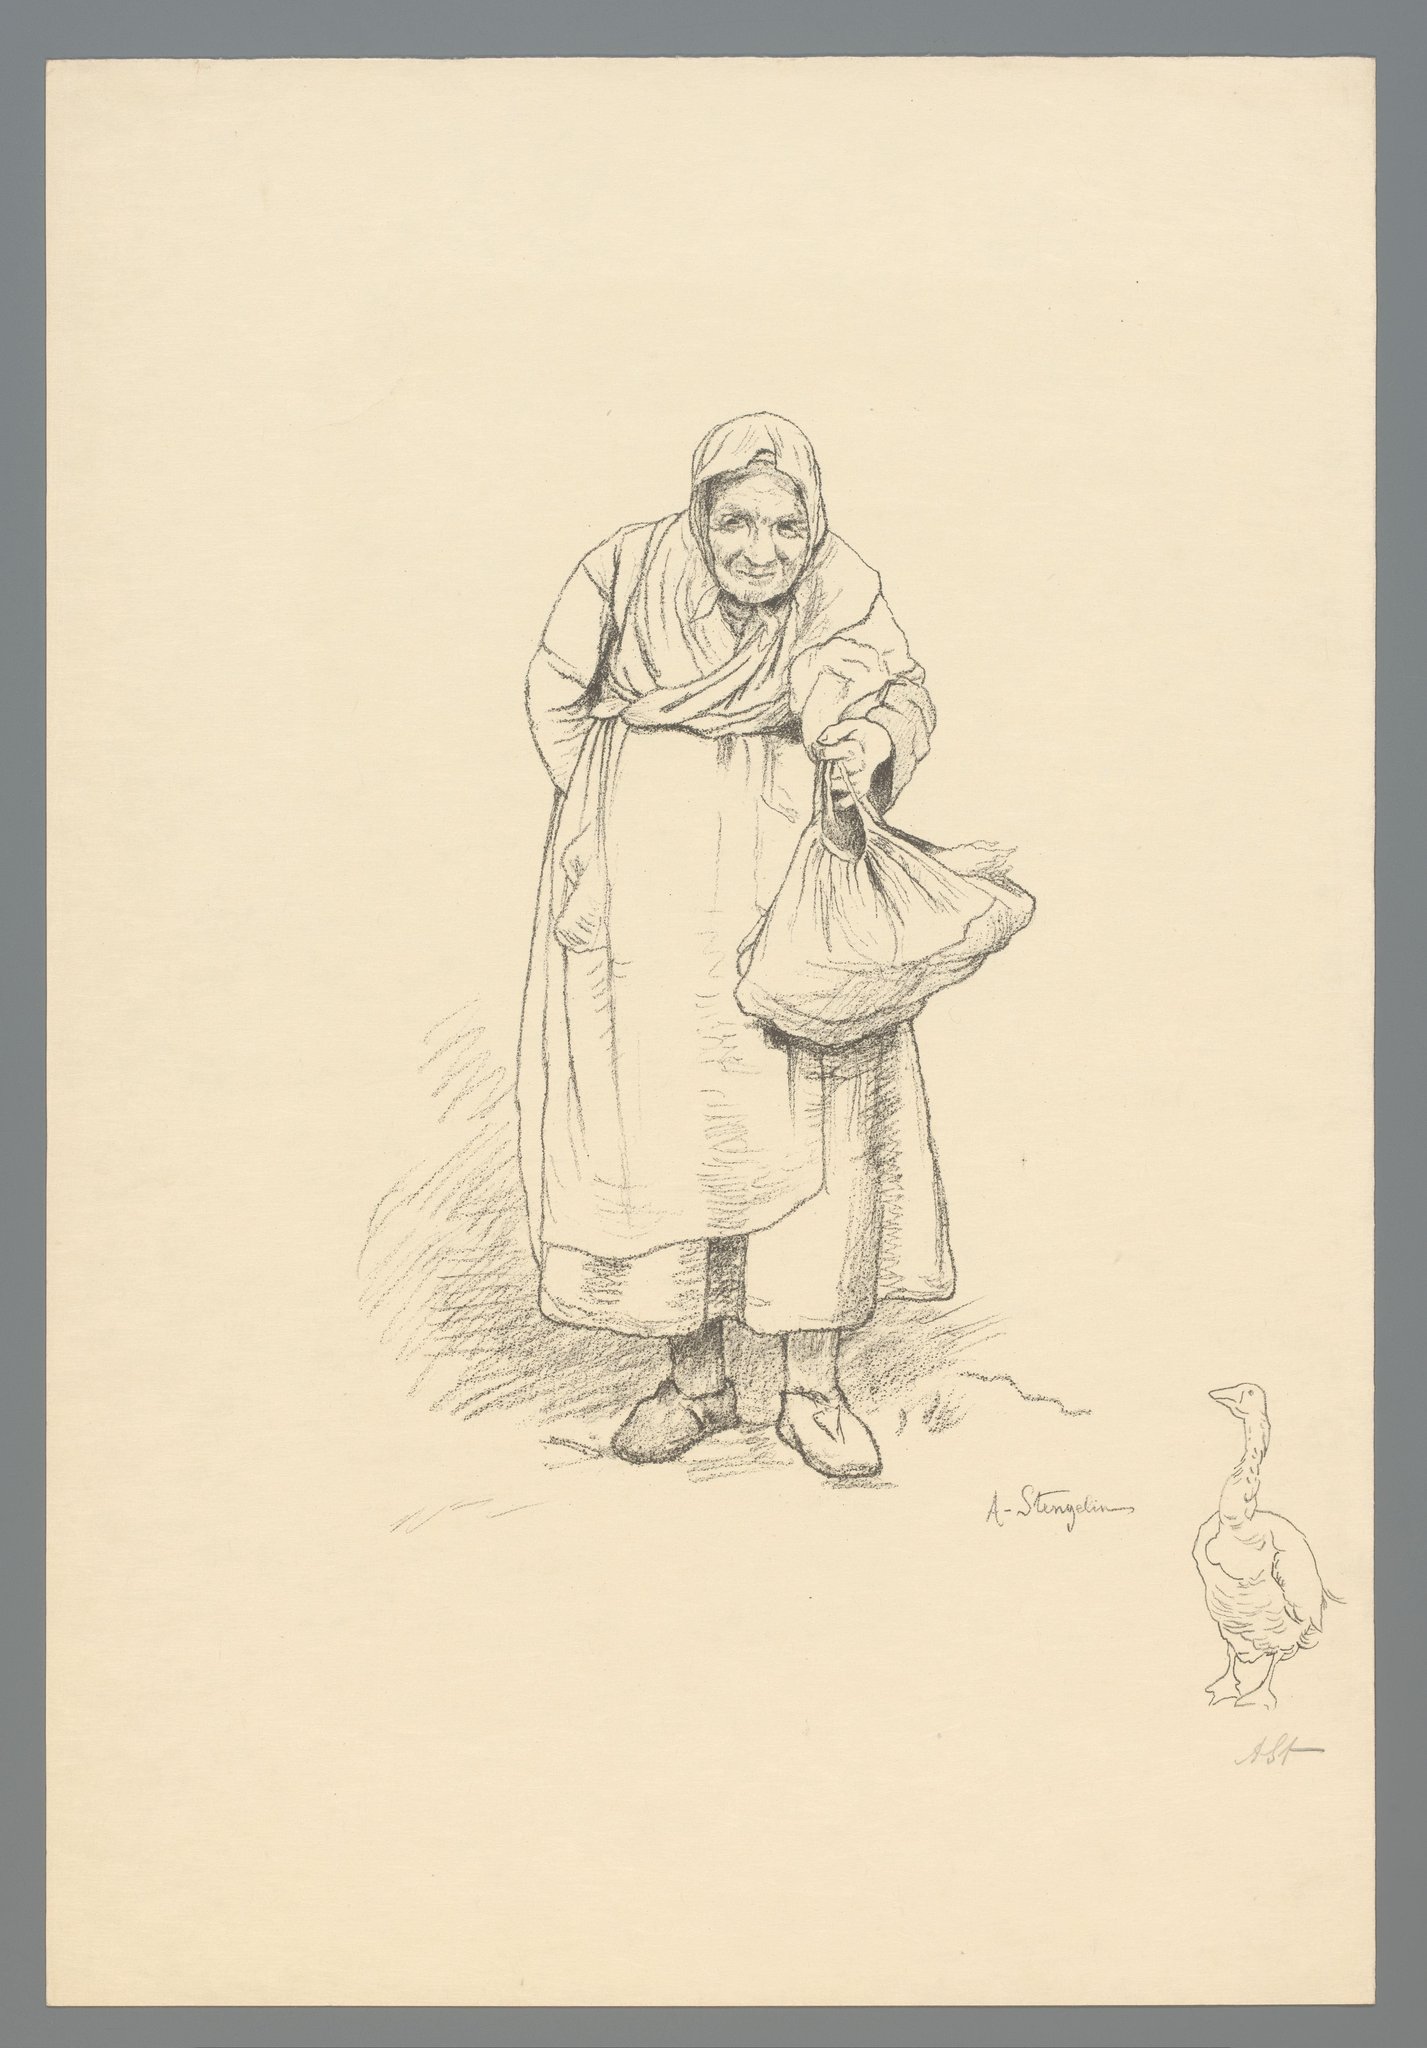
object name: print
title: Oude vrouw met een tas in de hand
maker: alphonse stengelin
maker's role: painter, print maker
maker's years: 1852-1938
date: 1876-1910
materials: paper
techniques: lithograph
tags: old woman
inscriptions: collector's mark: Lugt 2228